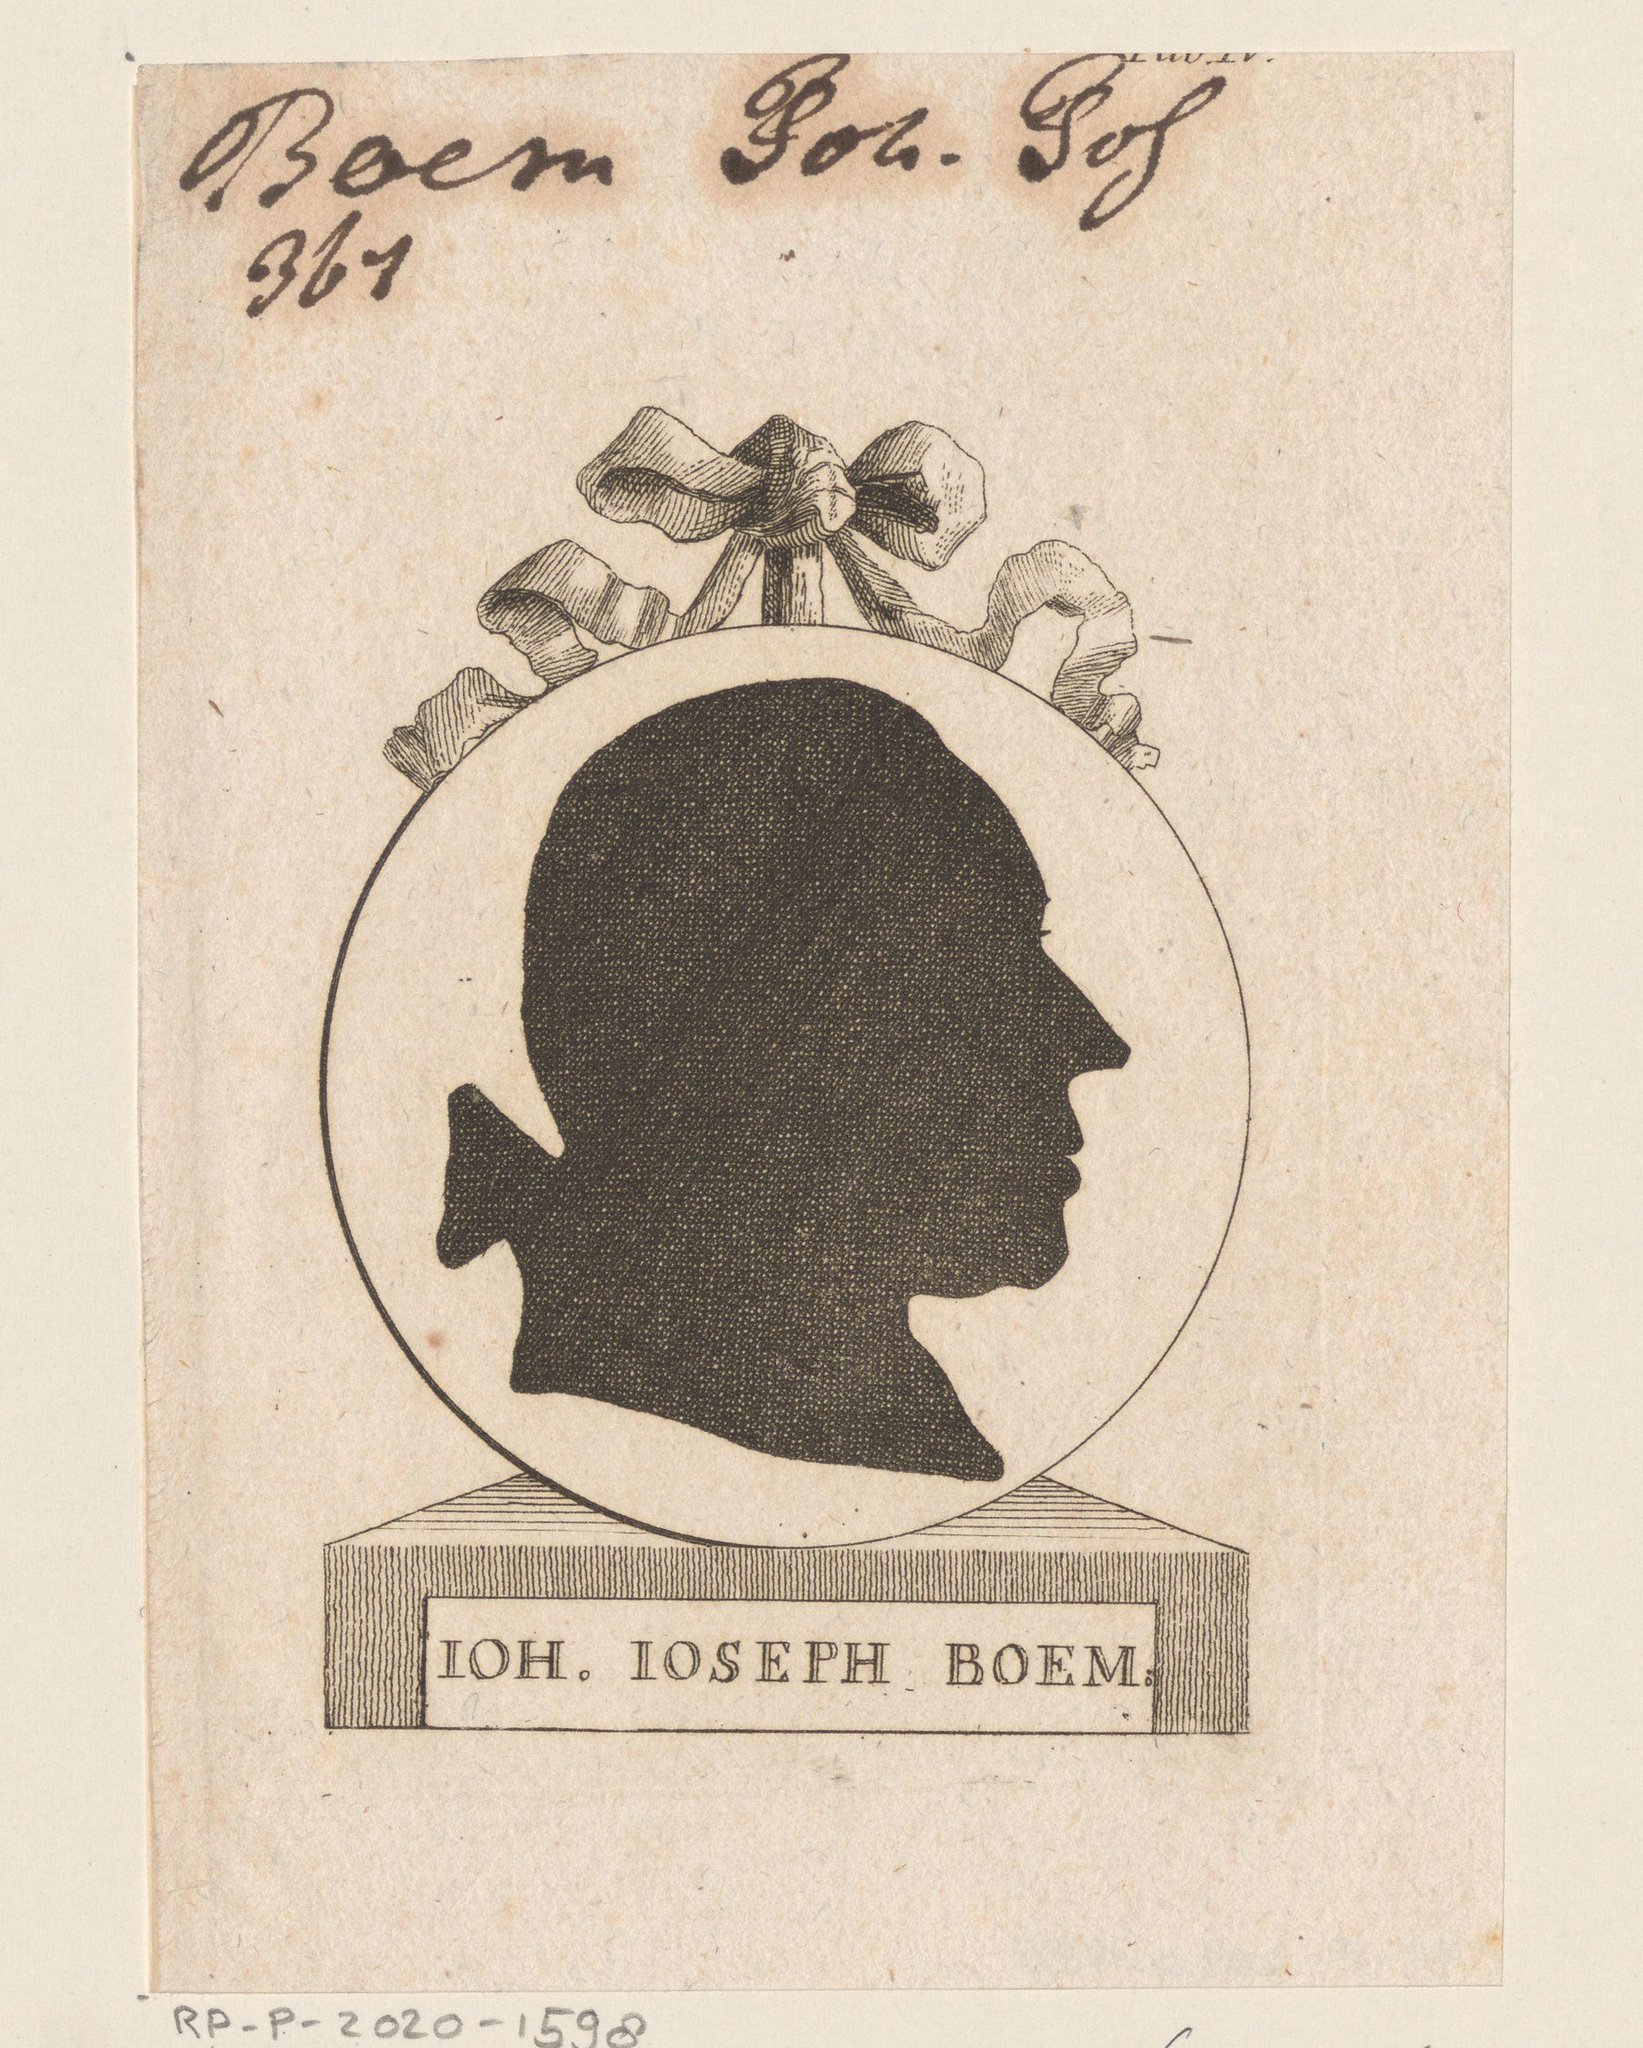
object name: book illustration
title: Silhouetportret van Johann Joseph Boem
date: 1783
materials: paper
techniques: etching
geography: halle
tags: historical persons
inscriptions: inscription: ‘Boem Joh Jos 361’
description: Prent uit: Schattenrisse edler Teutschen. Aus dem Tagebuche eines physiognomischen Reisenden. Halle: Johann Christian Hendel, 1783, dl. 1.